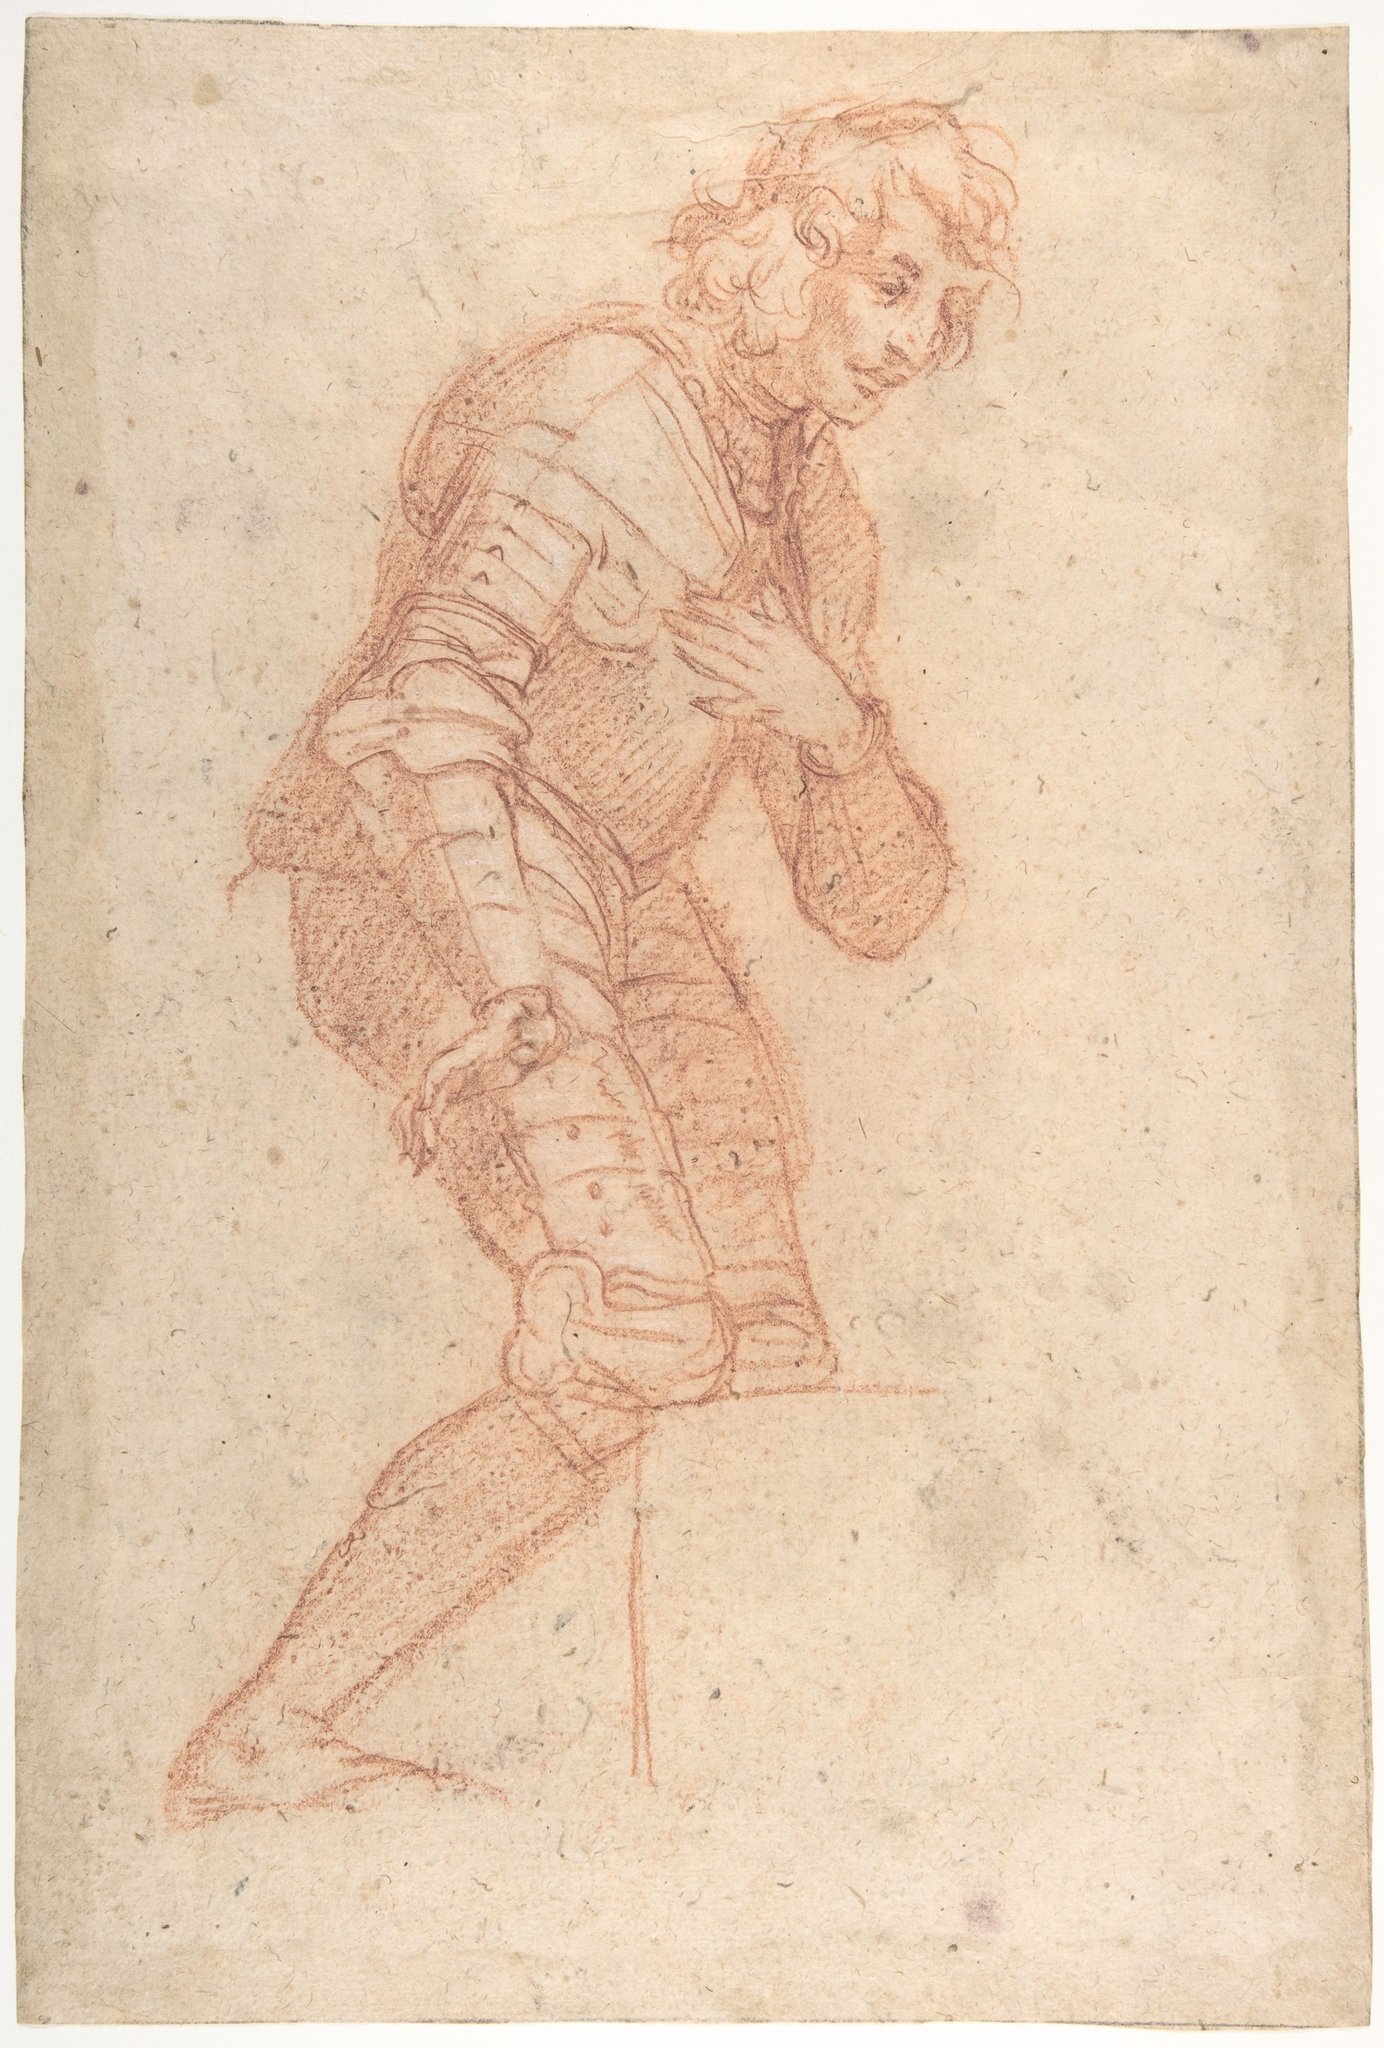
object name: drawing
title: Kneeling Youth in Armour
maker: baldassarre franceschini (il volterrano)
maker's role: artist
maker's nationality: italian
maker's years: 1611-1690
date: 1611-1689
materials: chalk, paper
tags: armor,men